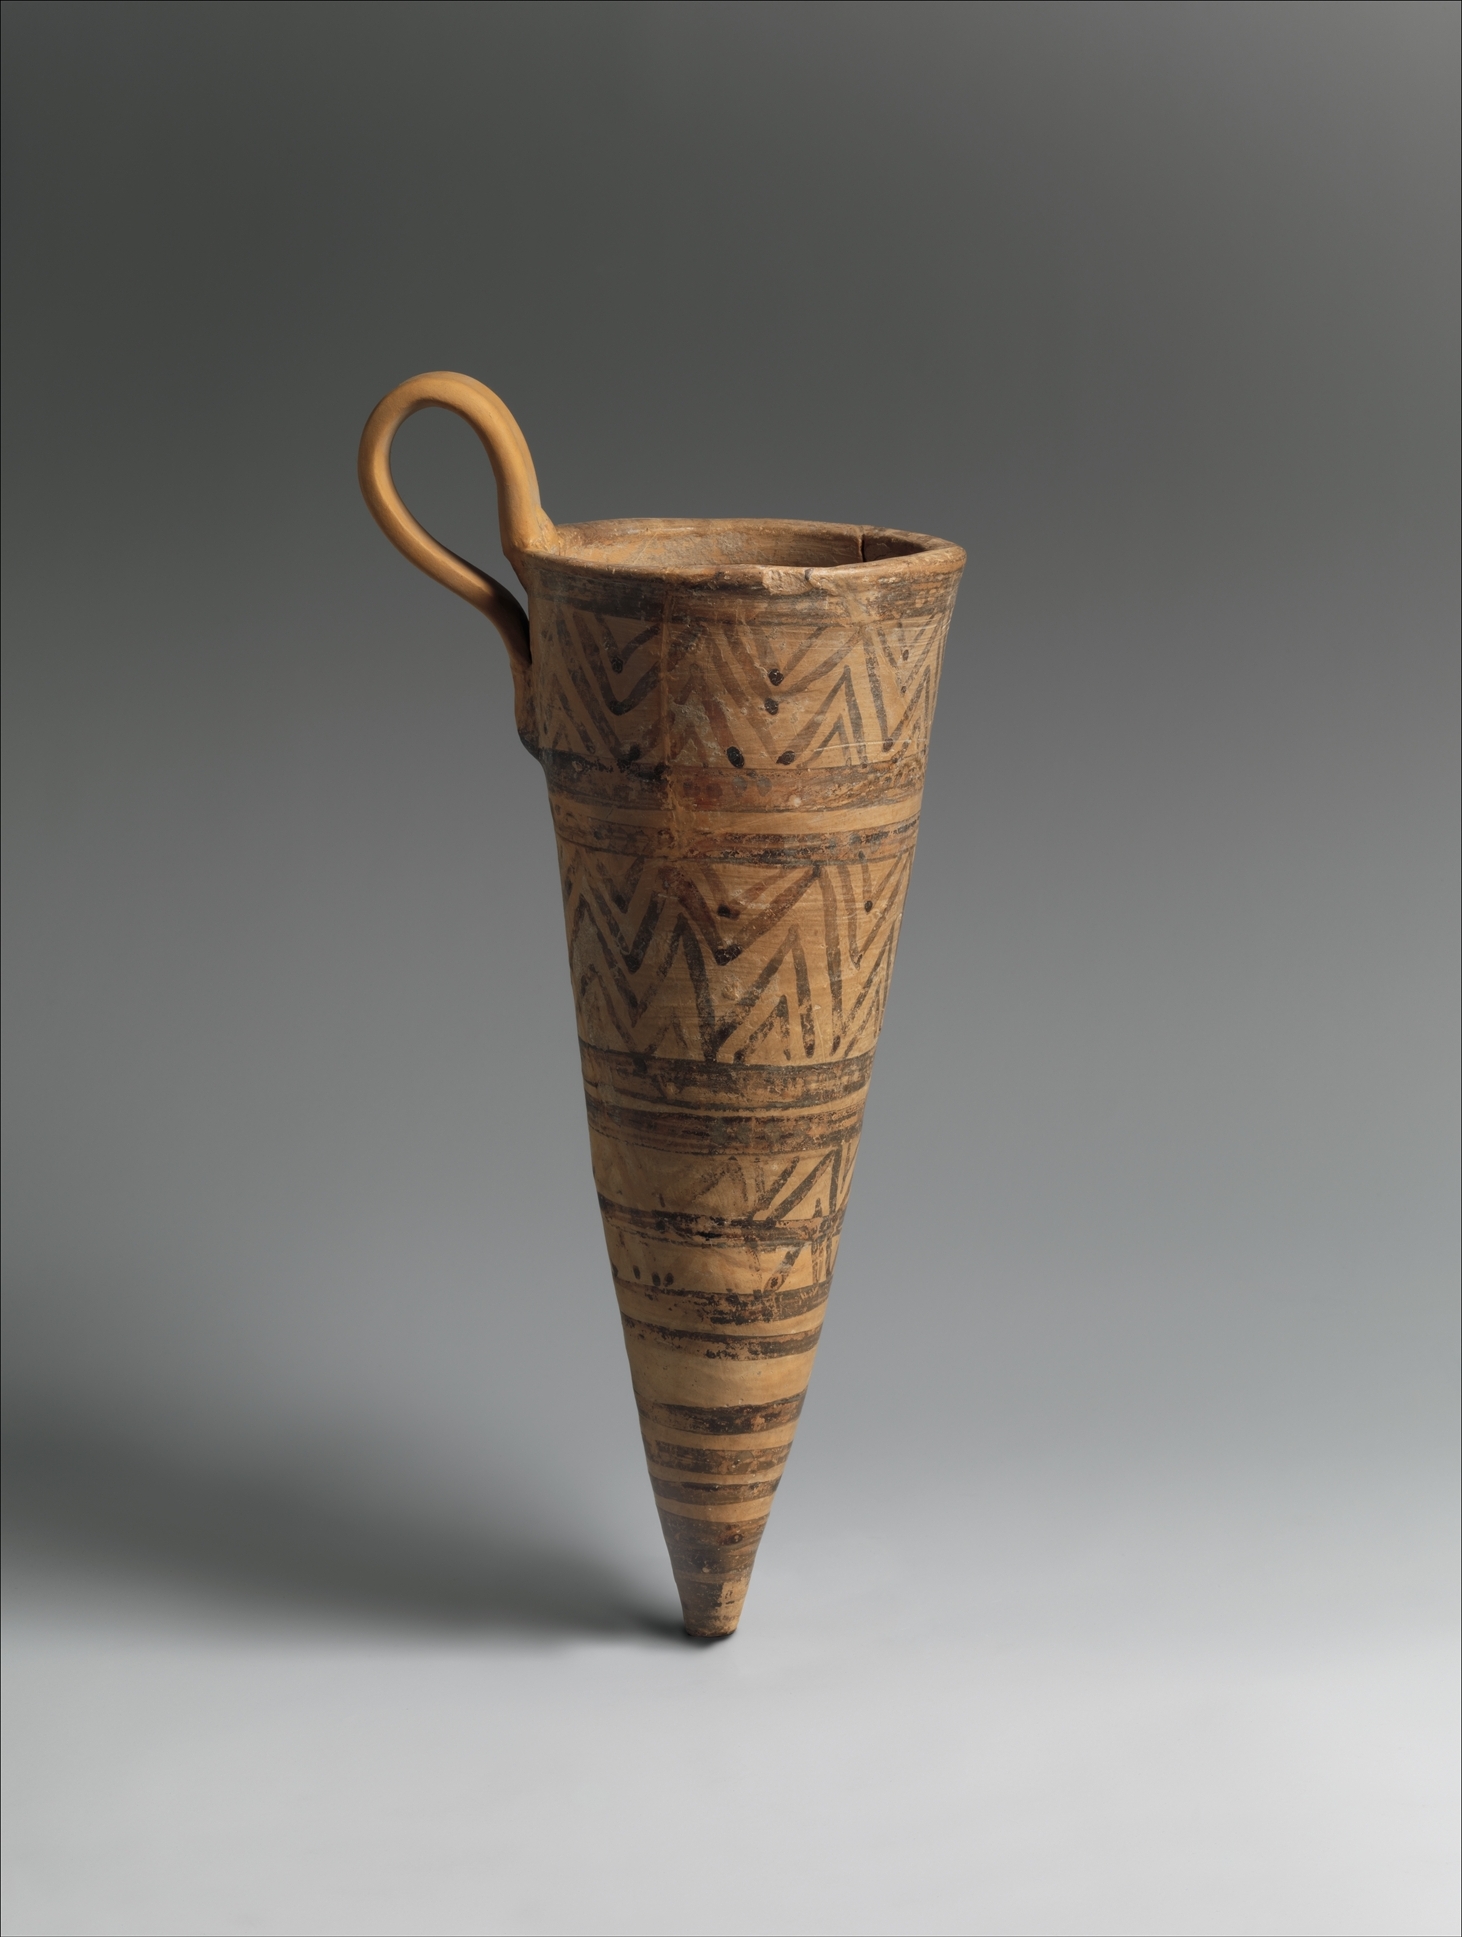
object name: rhyton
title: Terracotta conical rhyton (vase for liquid offerings)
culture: minoan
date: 1600-1500 BCE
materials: terracotta